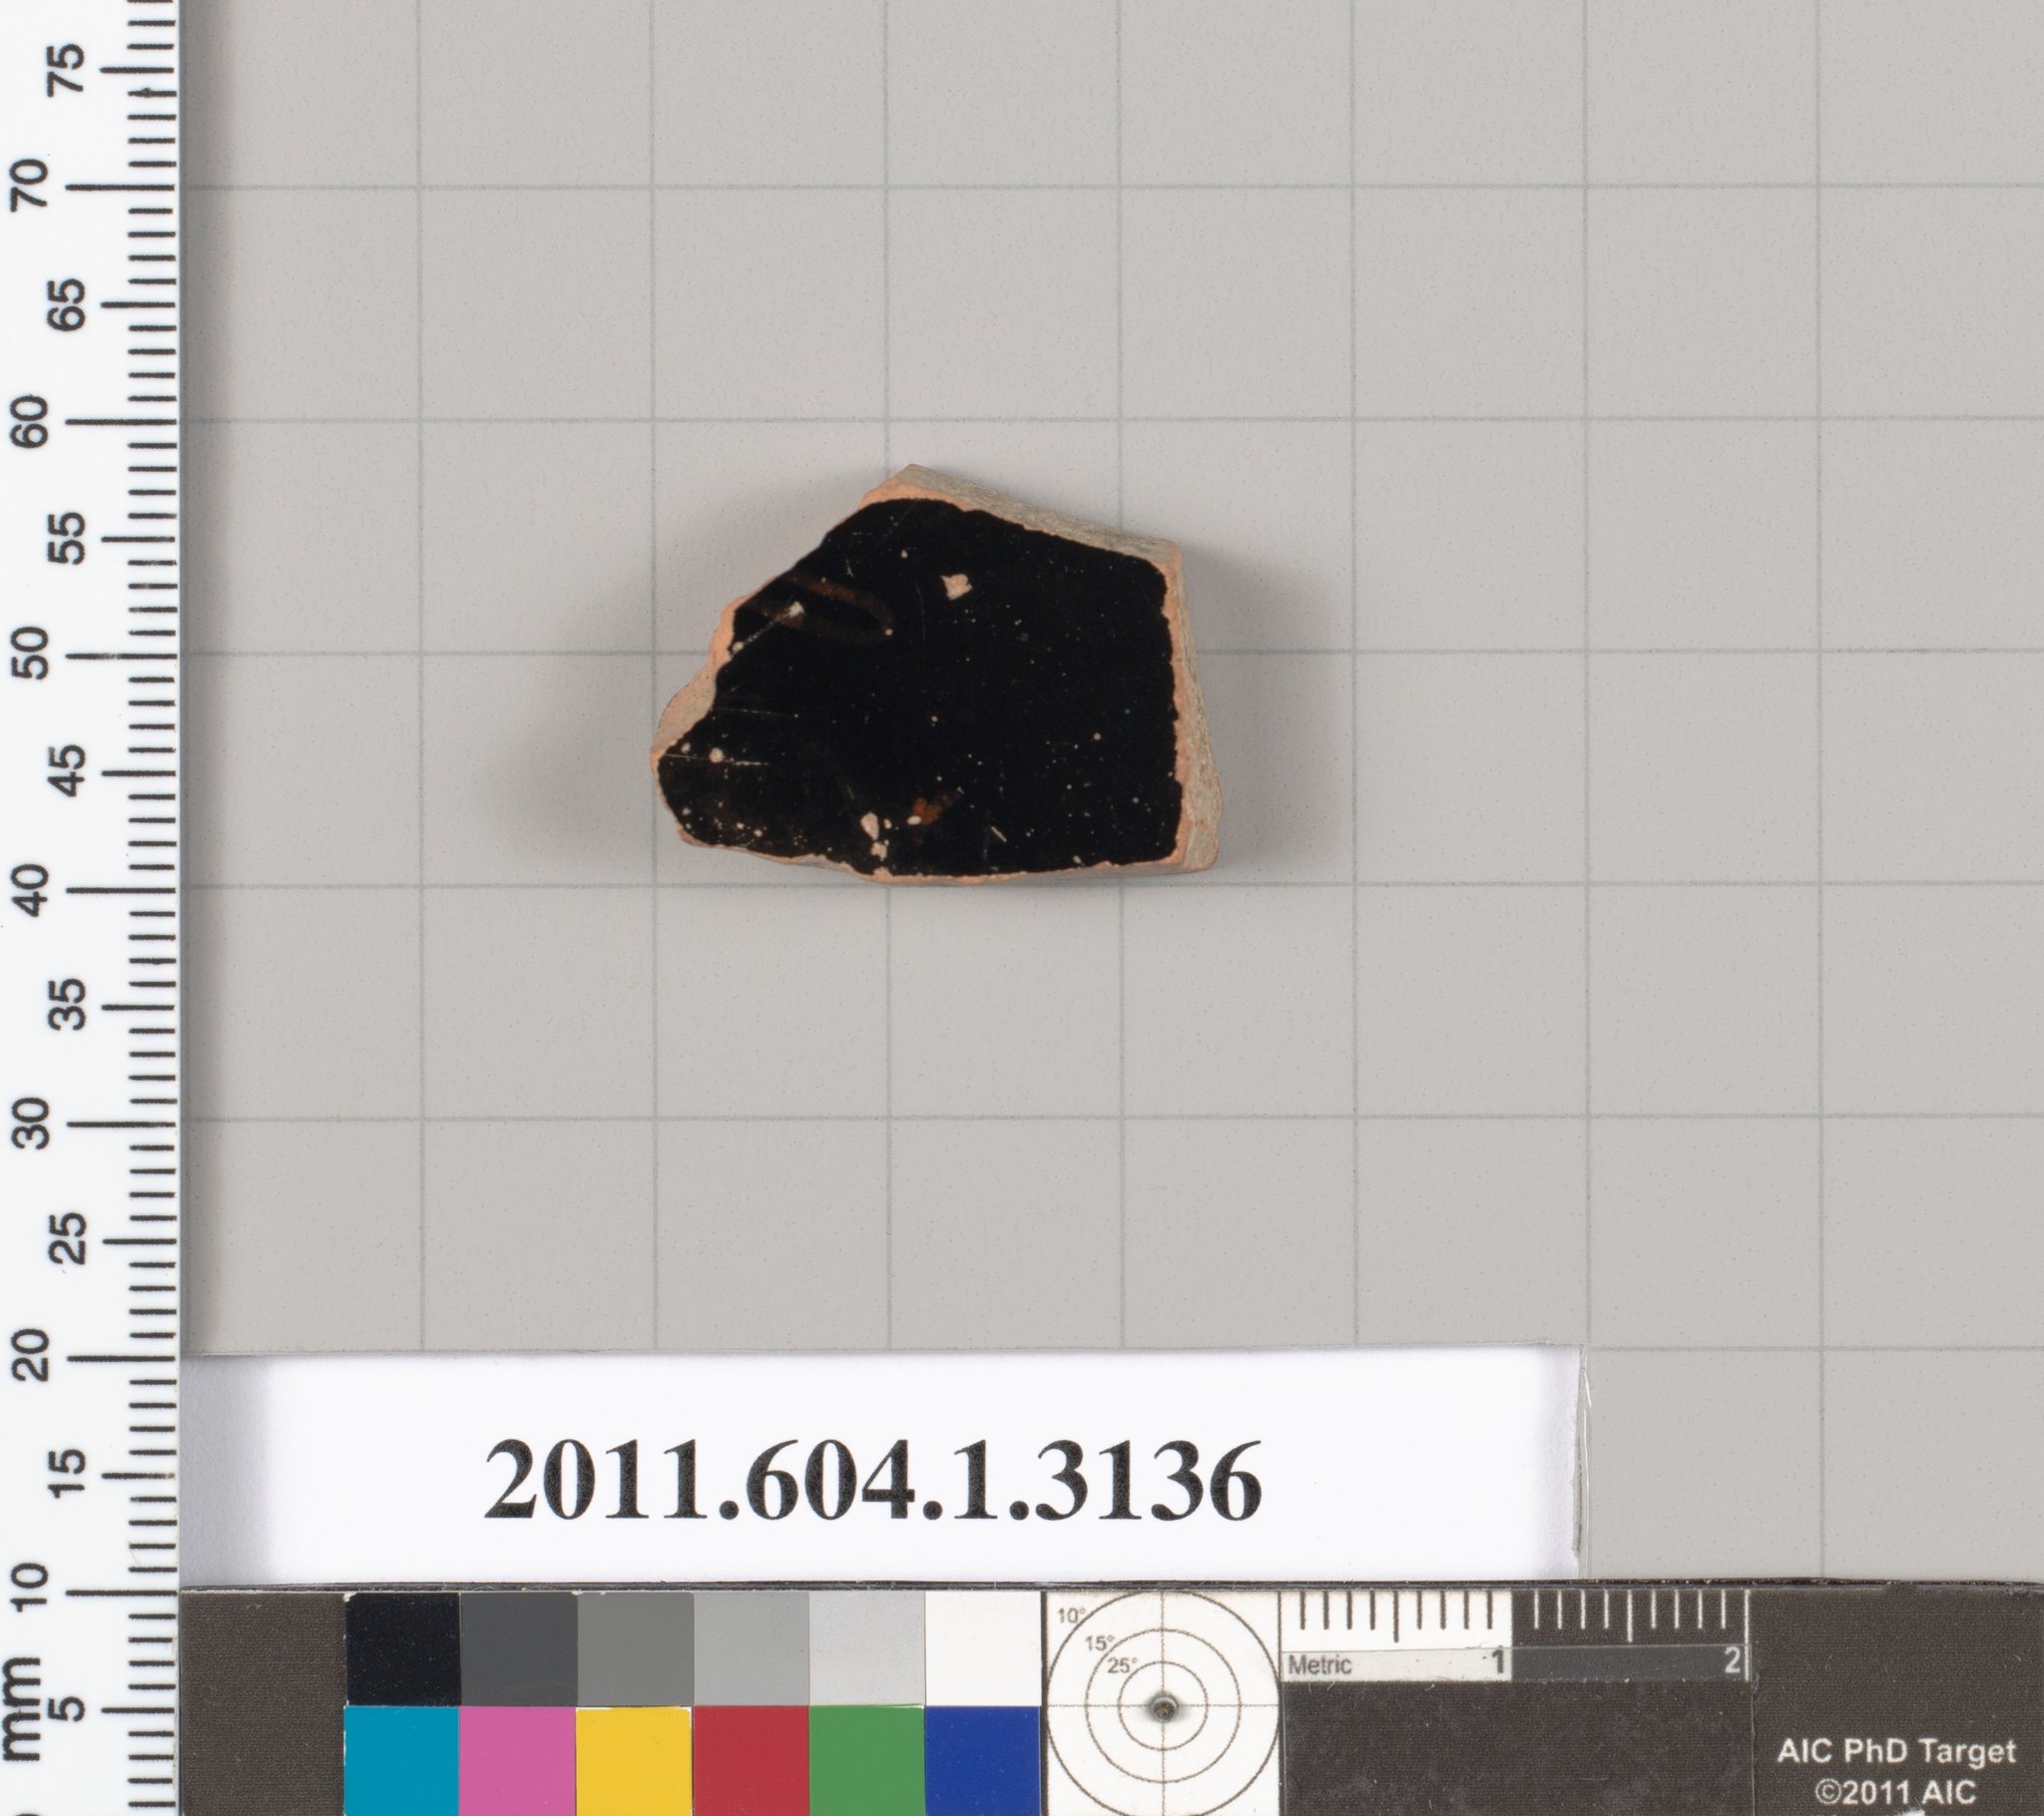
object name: kylix fragment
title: Terracotta fragment of a kylix (drinking cup)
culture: greek, attic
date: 500-451 BCE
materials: terracotta